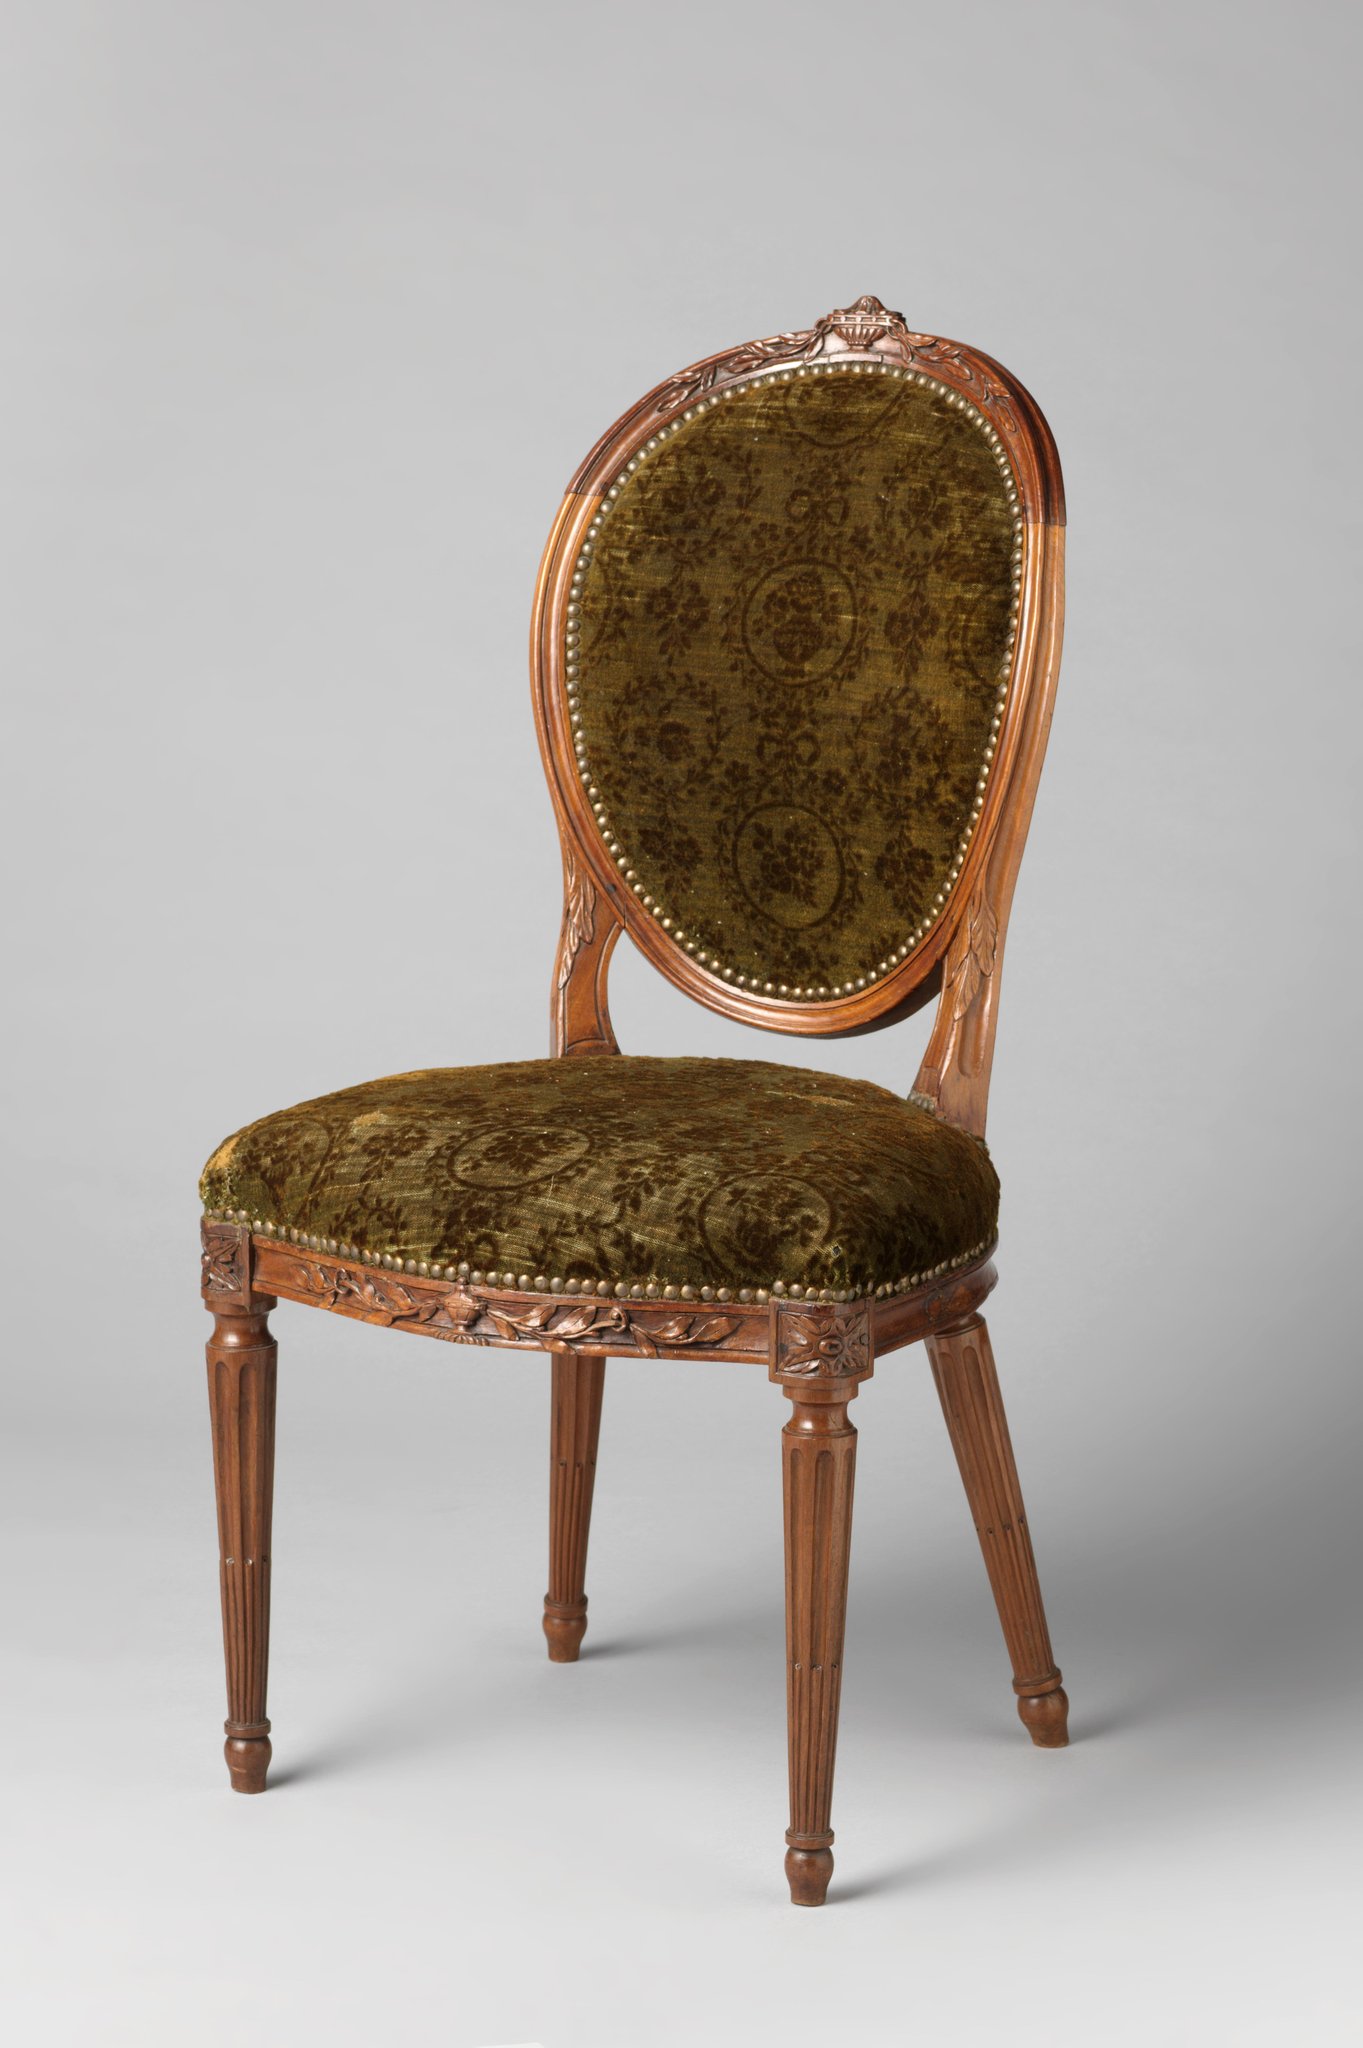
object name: chair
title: Stoel van mahoniehout, bekleed met groene trijp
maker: Anonymous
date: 1775-1800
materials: wood, textile, velvet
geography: northern netherlands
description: Armchair. Mahogany, the velvet upholstery has been renewed. Netherlands, c. 1780 - 1800. Given by Mr and Mrs Drucker-Fraser, 1922.